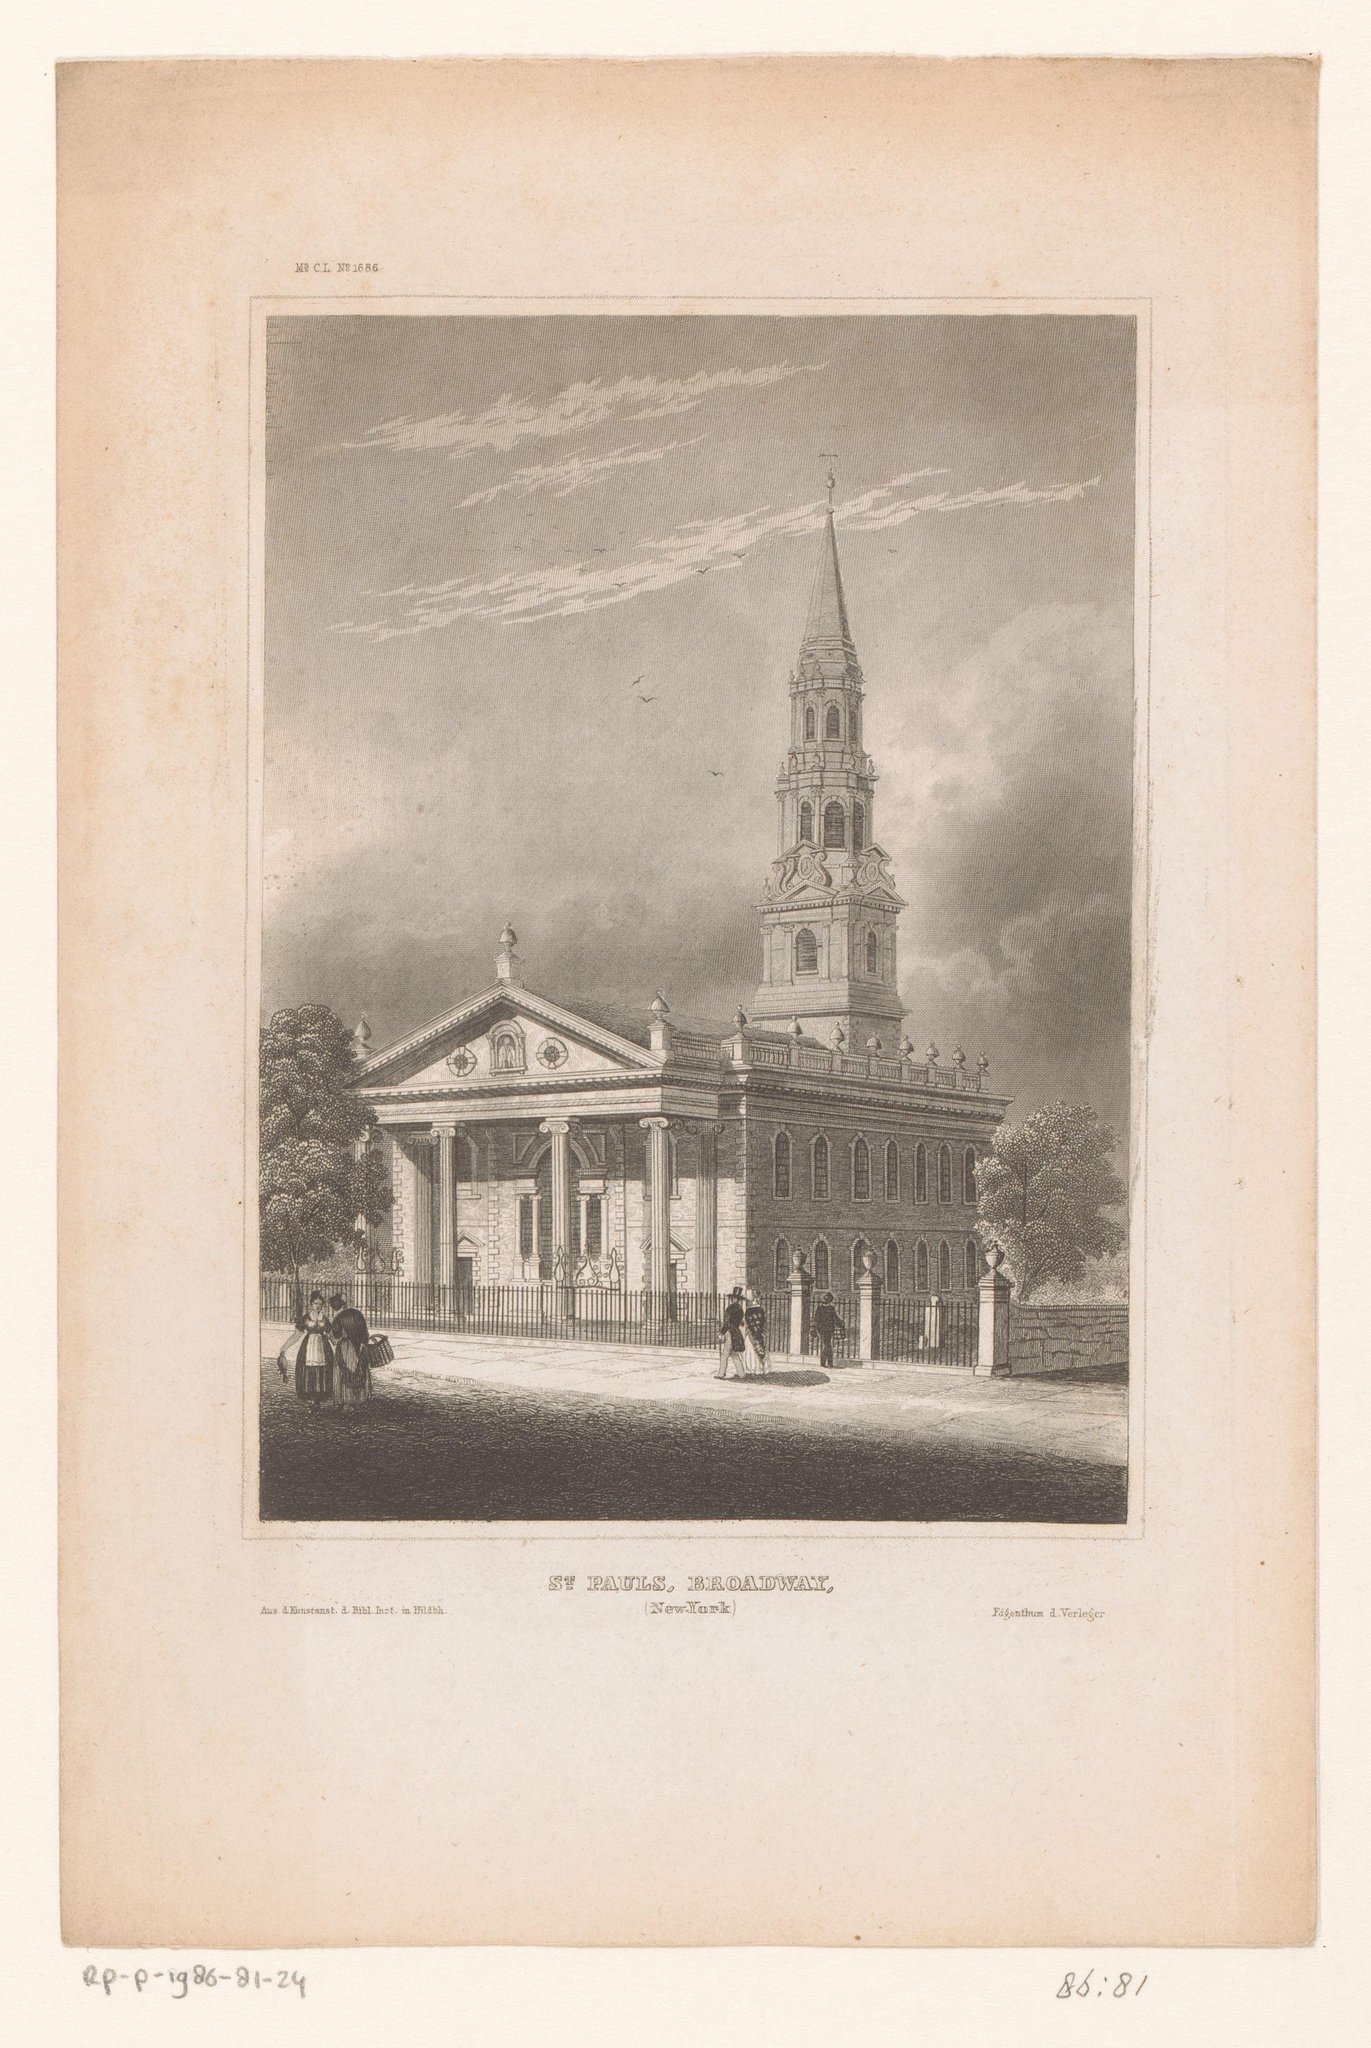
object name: print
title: St Pauls, Broadway New York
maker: Anonymous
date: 1835-1863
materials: paper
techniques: engraving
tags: church (exterior), new york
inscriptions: collector's mark: Lugt 2760, collector's mark: Lugt 2228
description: Prent verschenen in: Meyer, Joseph. Meyer's Universum. Hildburghausen: Bibliographisches Institut, 1835-1863.